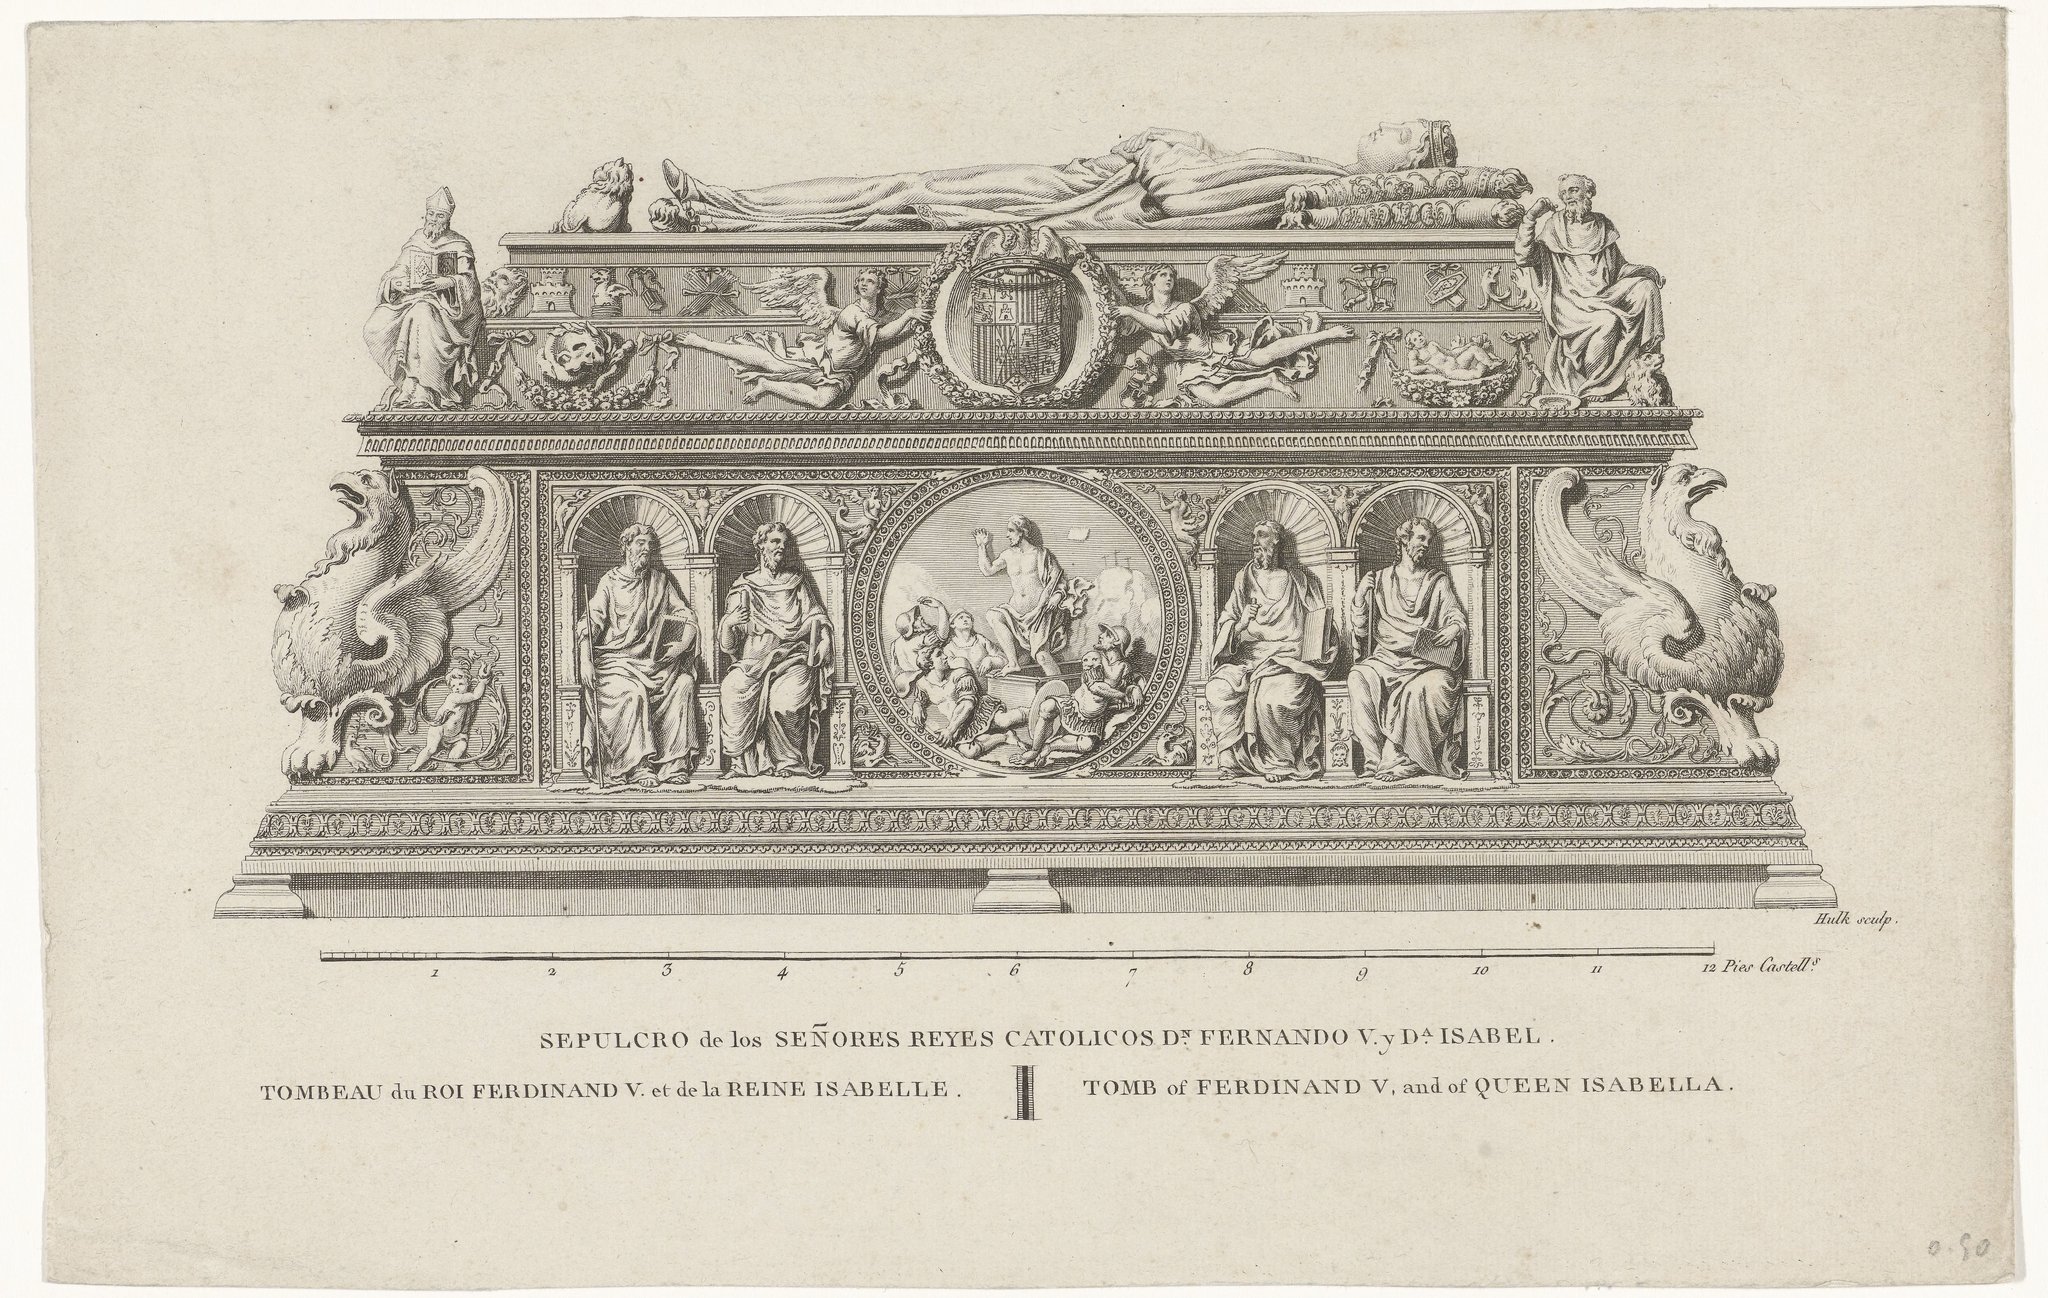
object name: print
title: Graftombe voor Ferdinand II de Katholieke, koning van Aragón en Isabella I de Katholieke, koningin van Castilië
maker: abraham jacobsz. hulk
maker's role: print maker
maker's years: 1751-1817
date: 1766-1817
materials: paper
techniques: engraving, etching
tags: grave-building, monumental tomb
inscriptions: collector's mark: Lugt 2228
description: Praalgraf voor Ferdinand II de Katholieke en Isabella I de Katholieke. Bovenop de liggende grafsculptuur (gisant) van Isabella . Boven in het midden het wapen van Ferdinand II tussen twee engelen. In het tondo middenonder de opstanding van Christus. Links en rechts van deze voorstelling vier heiligen.